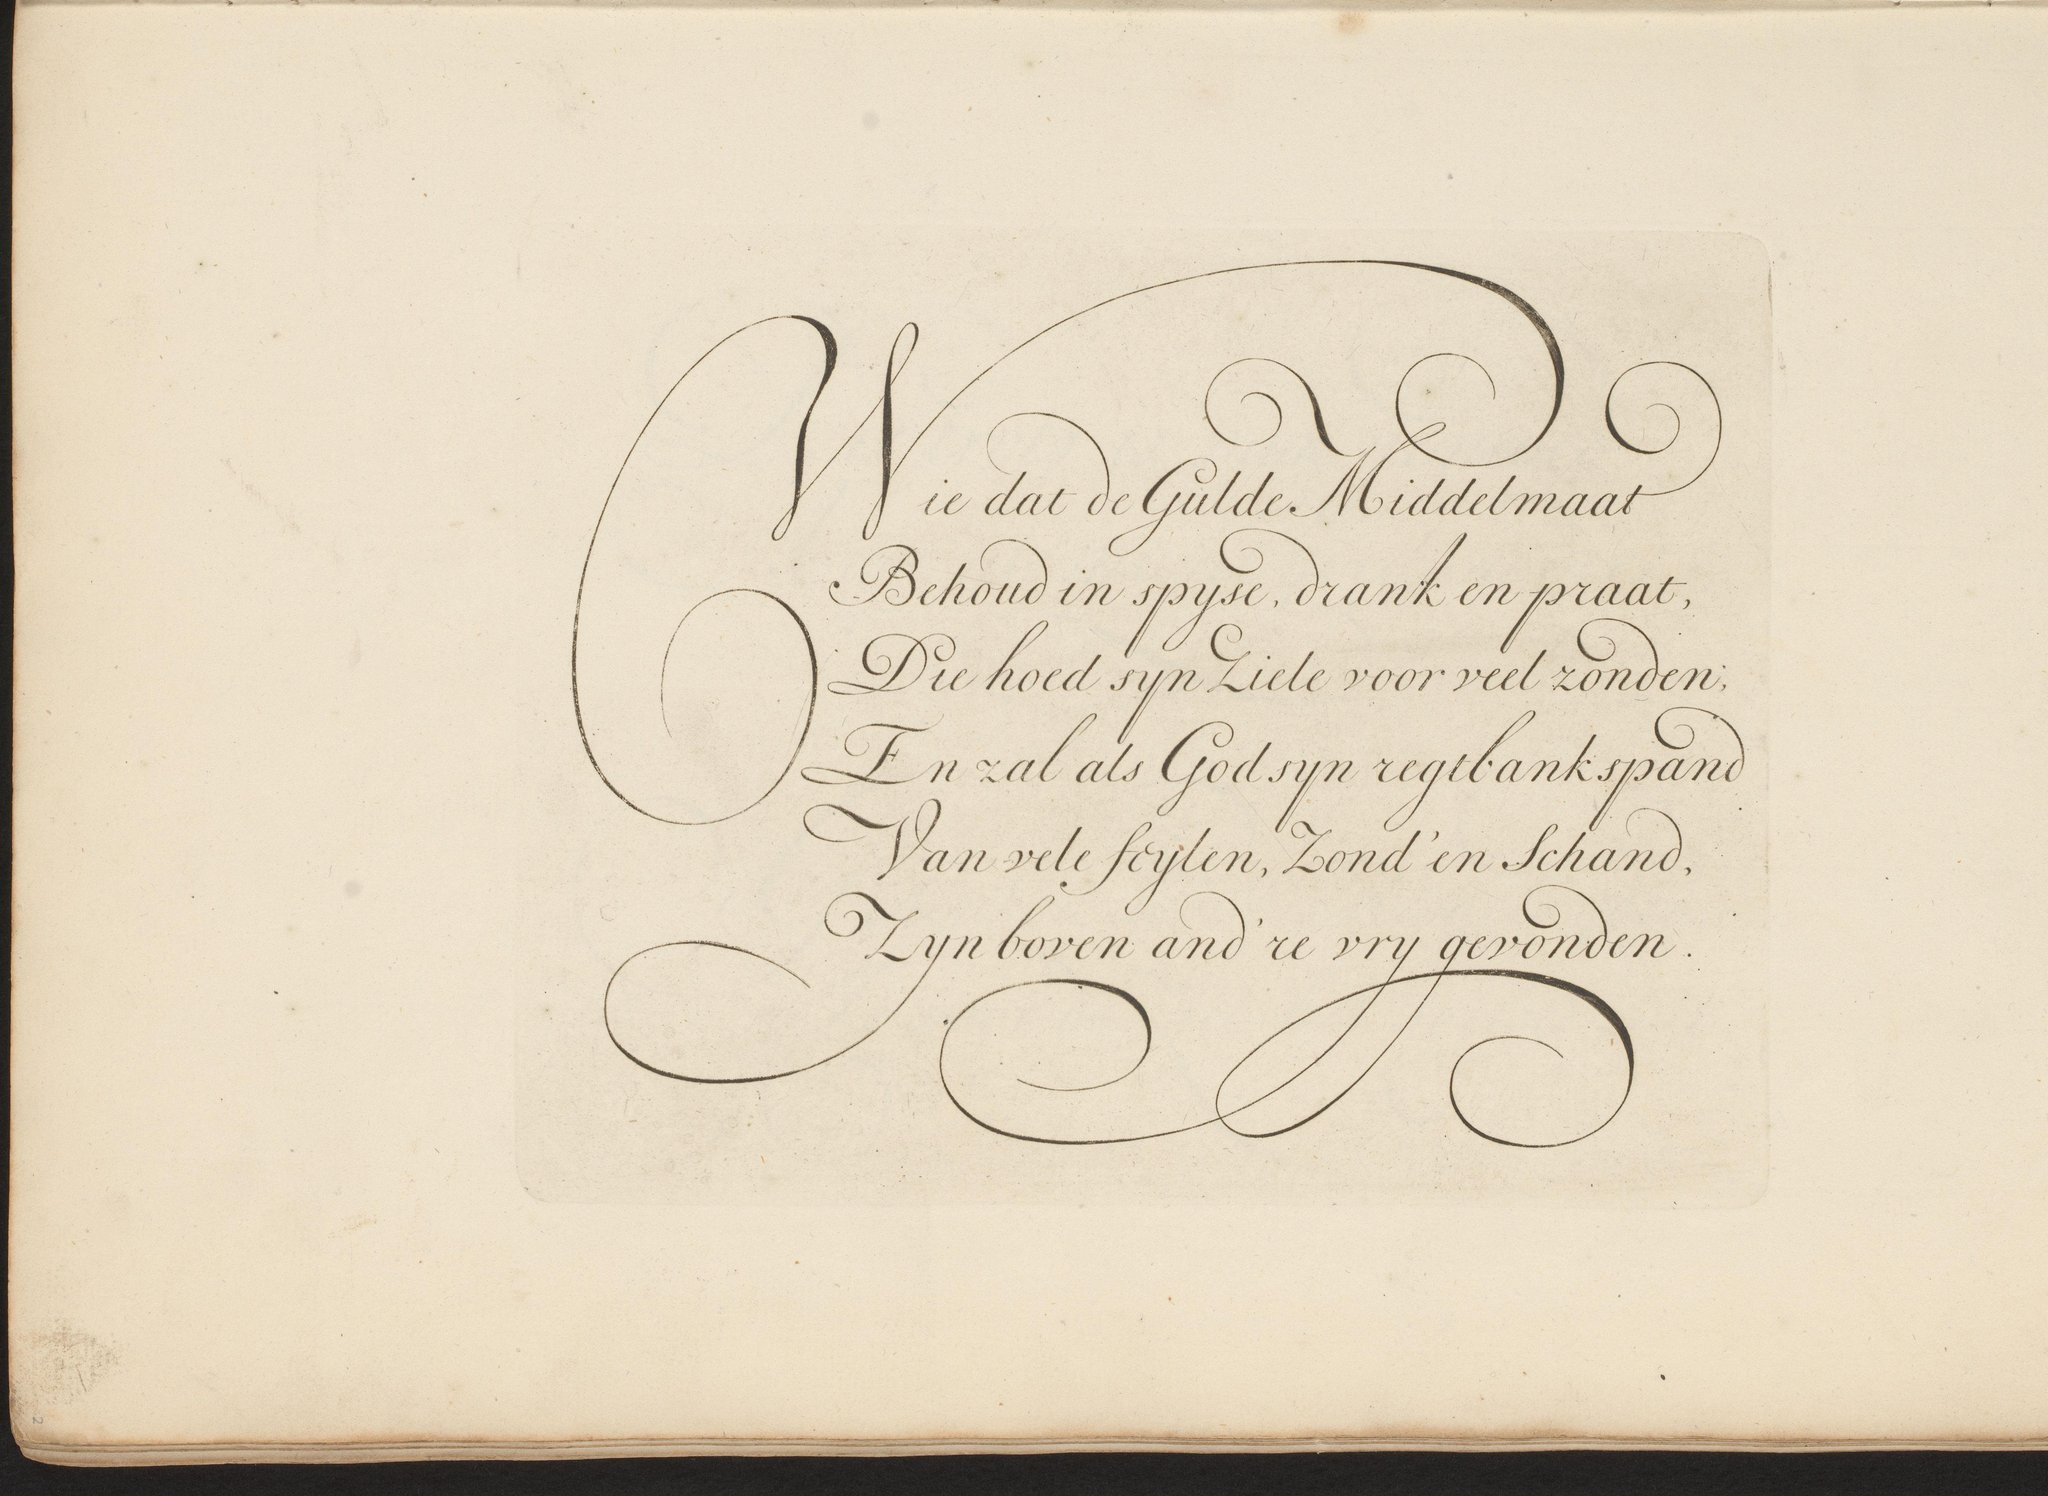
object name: ornament print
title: Schrijfvoorbeeld: Wie dat de Gulde Middelmaat (...)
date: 1660-1751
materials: paper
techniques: engraving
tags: calligraphy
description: Schrijfvoorbeeld met zes regels tekst in het Nederlands: Wie dat de Gulde Middelmaat ... De prent maakt deel uit van een album